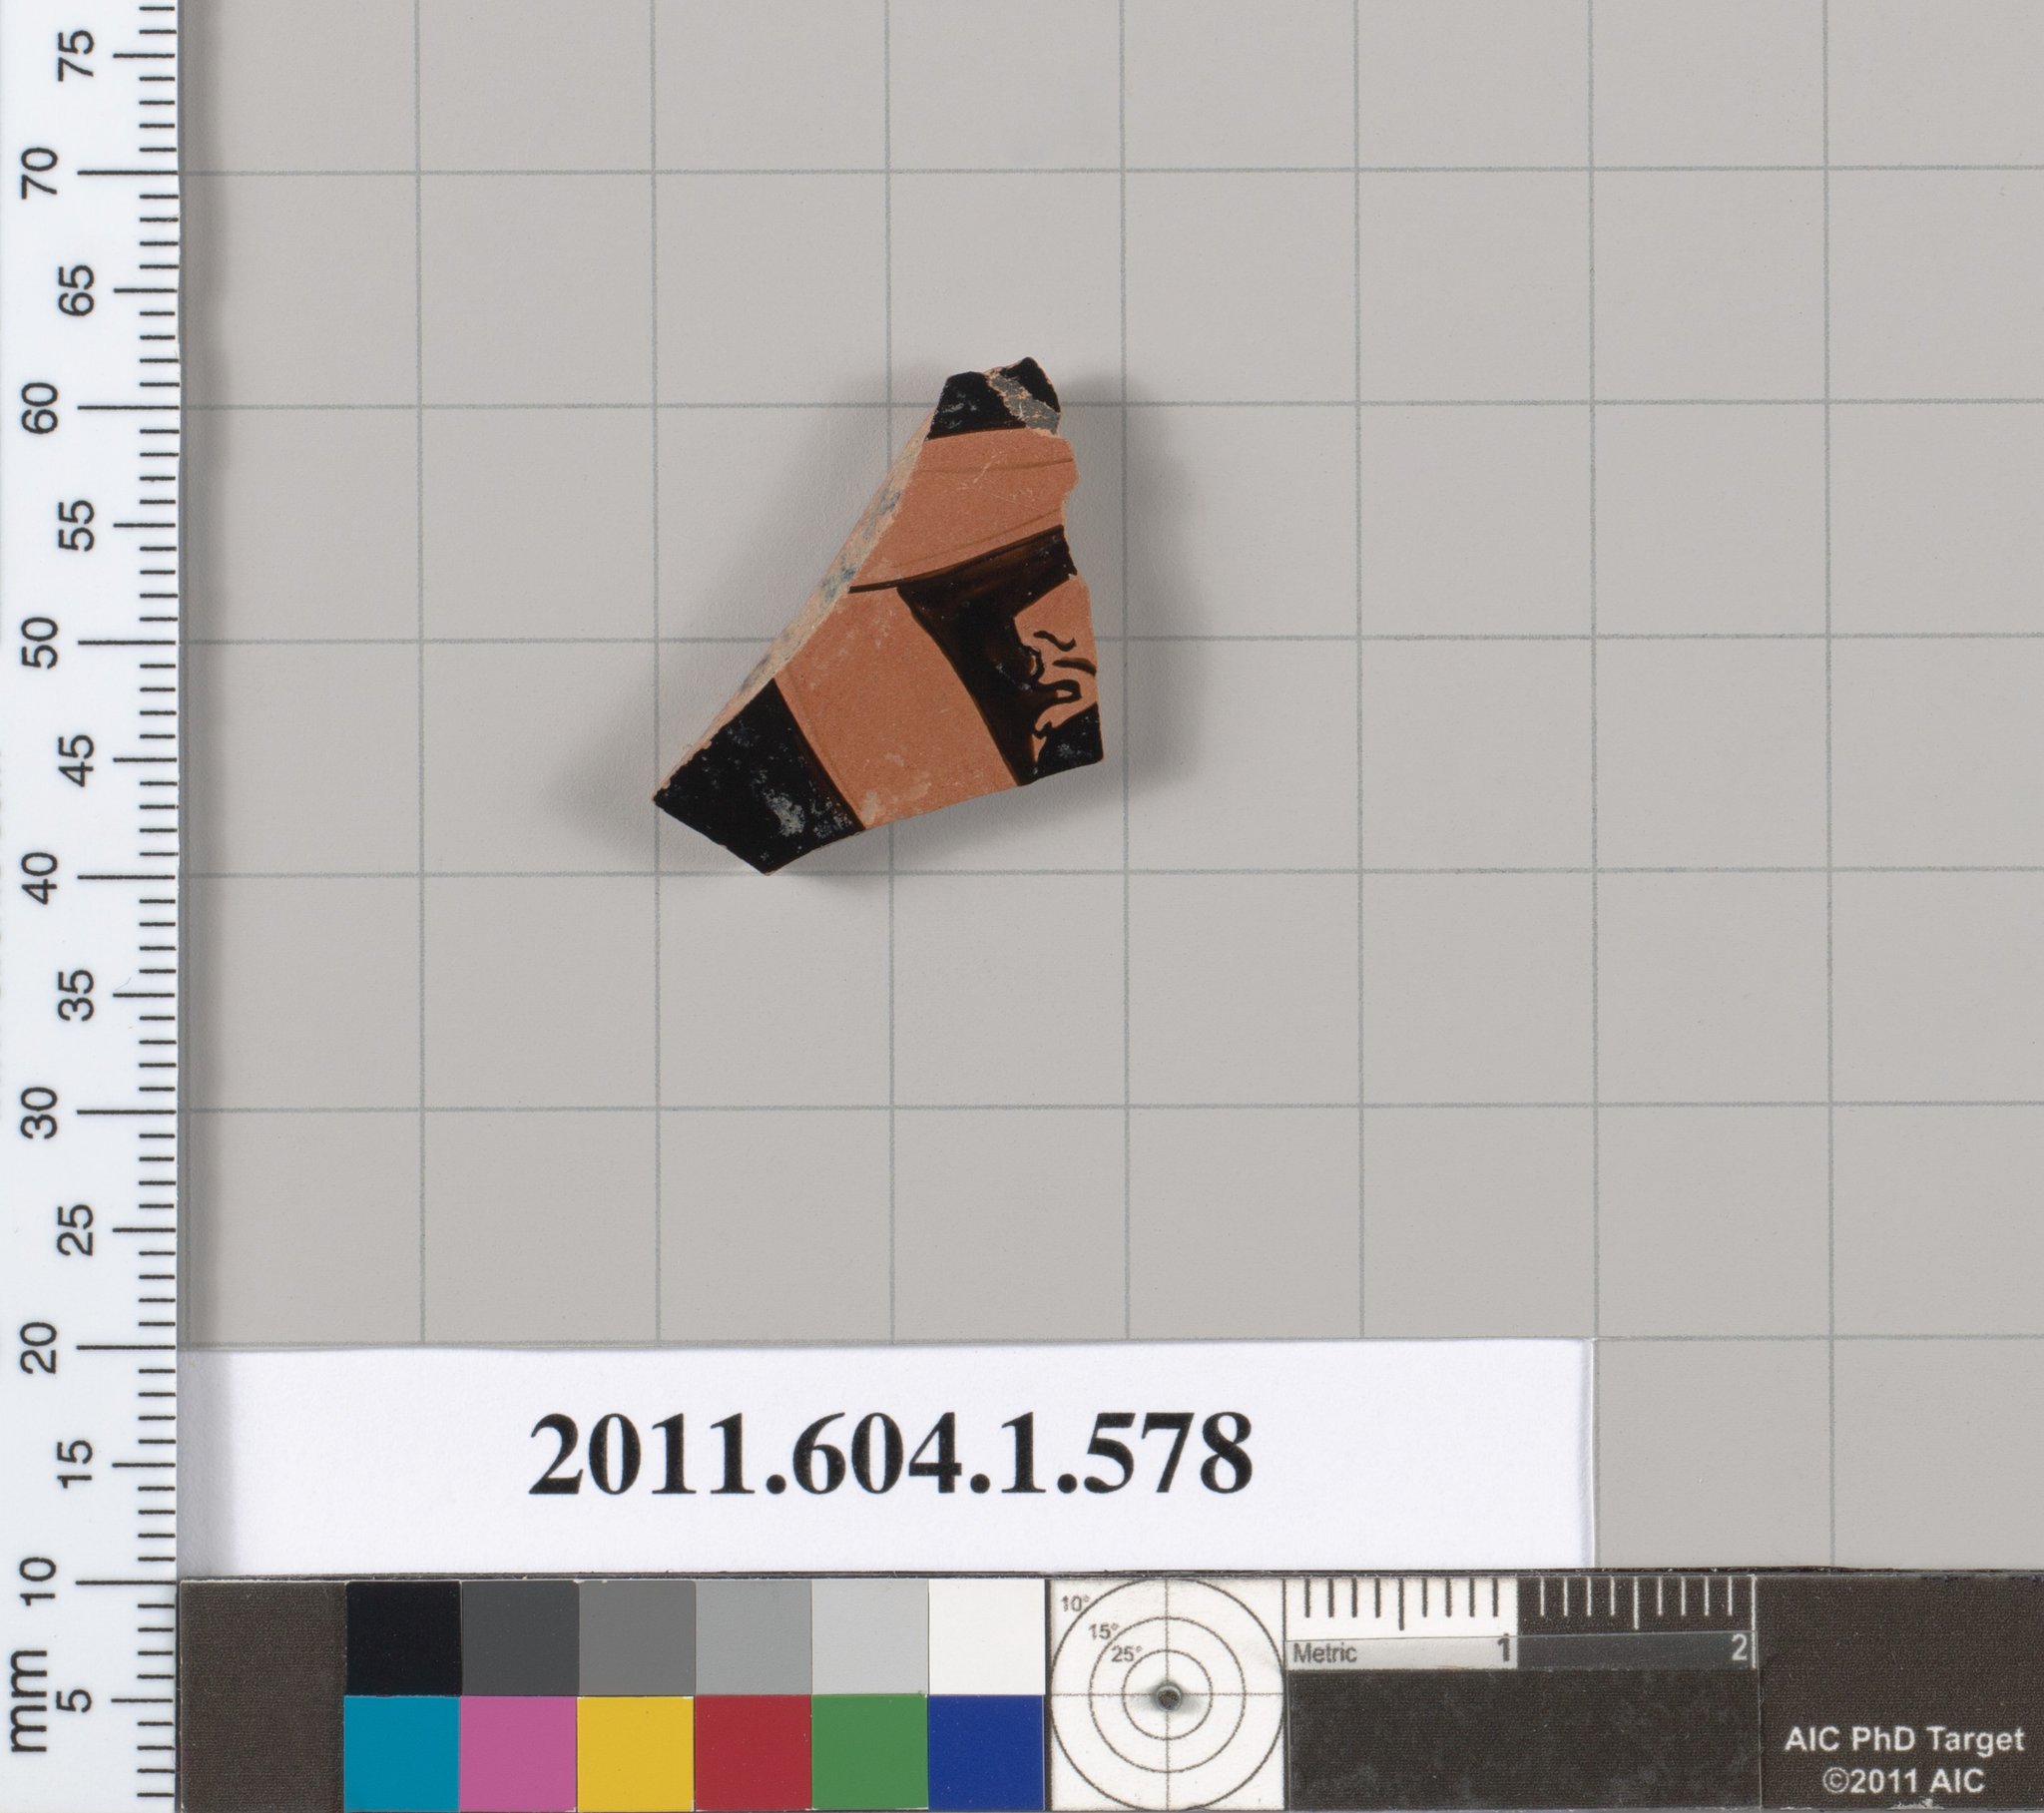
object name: kylix fragment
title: Terracotta fragment of a kylix (drinking cup)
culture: greek, attic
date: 490-480 BCE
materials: terracotta